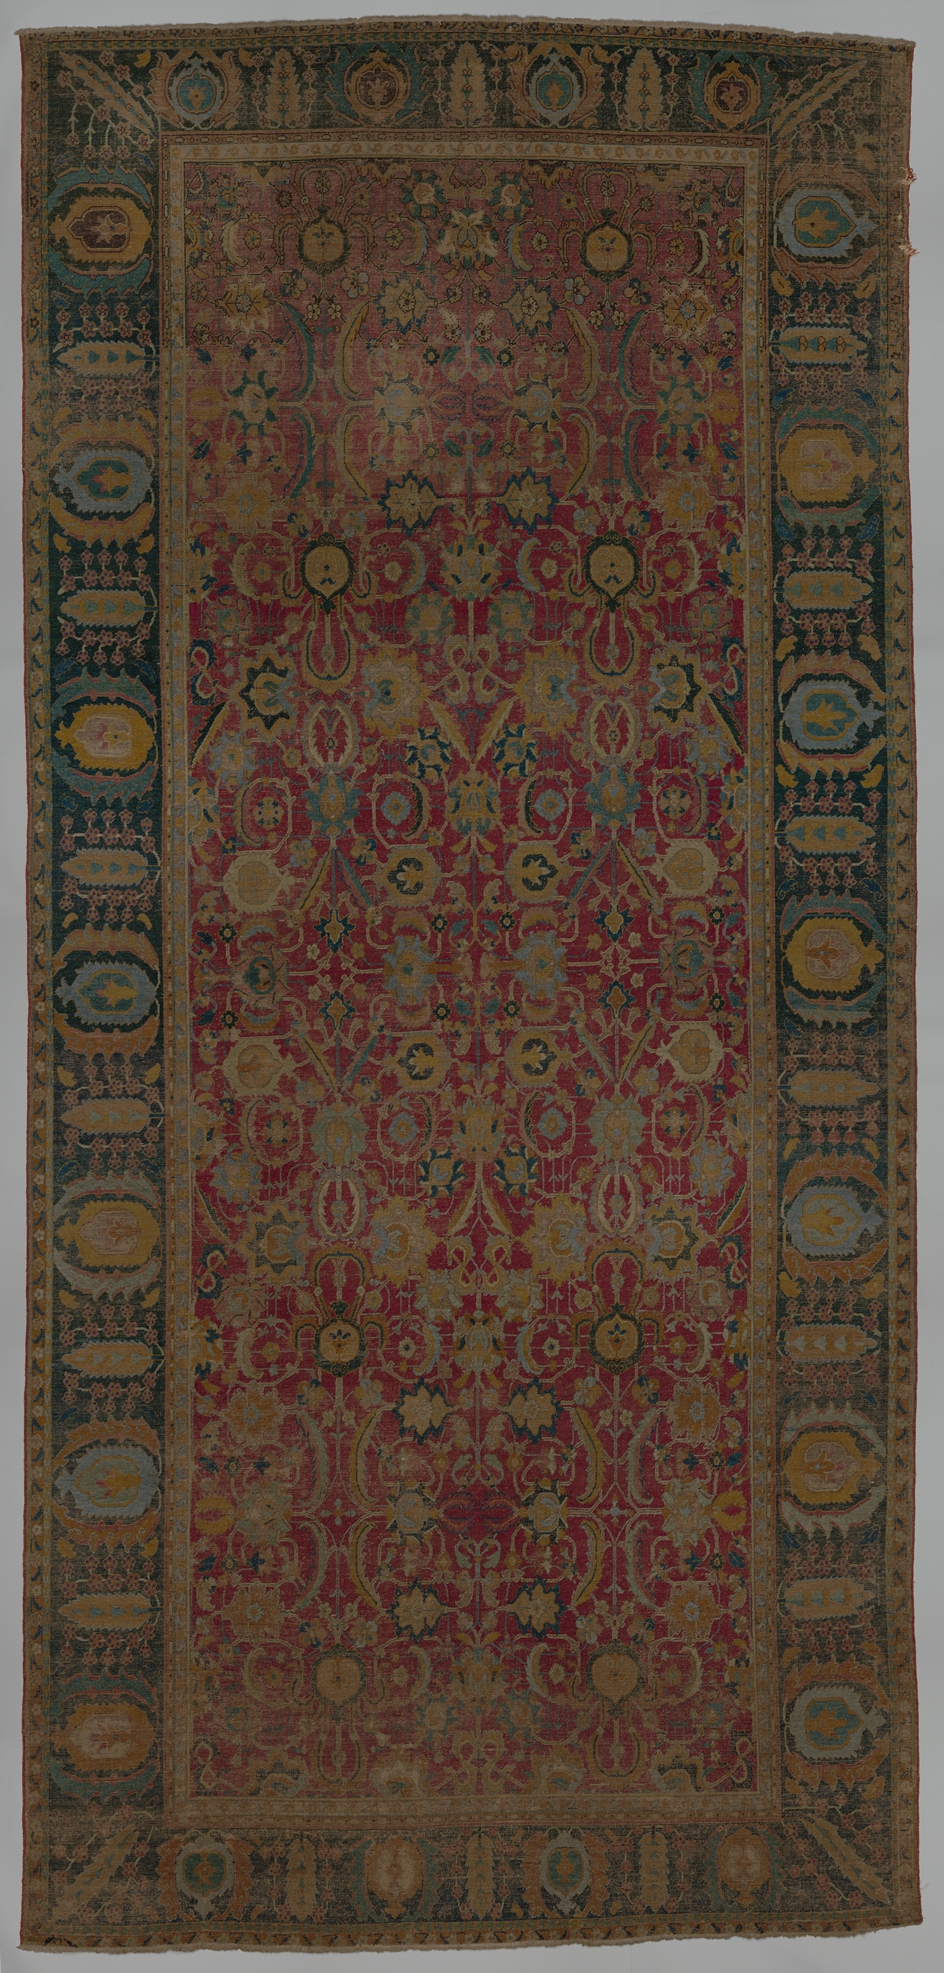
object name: carpet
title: Indo-Persian carpet with repeat pattern of vine scrolls and palmettes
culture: indo-persian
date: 1651-1700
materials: cotton, wool